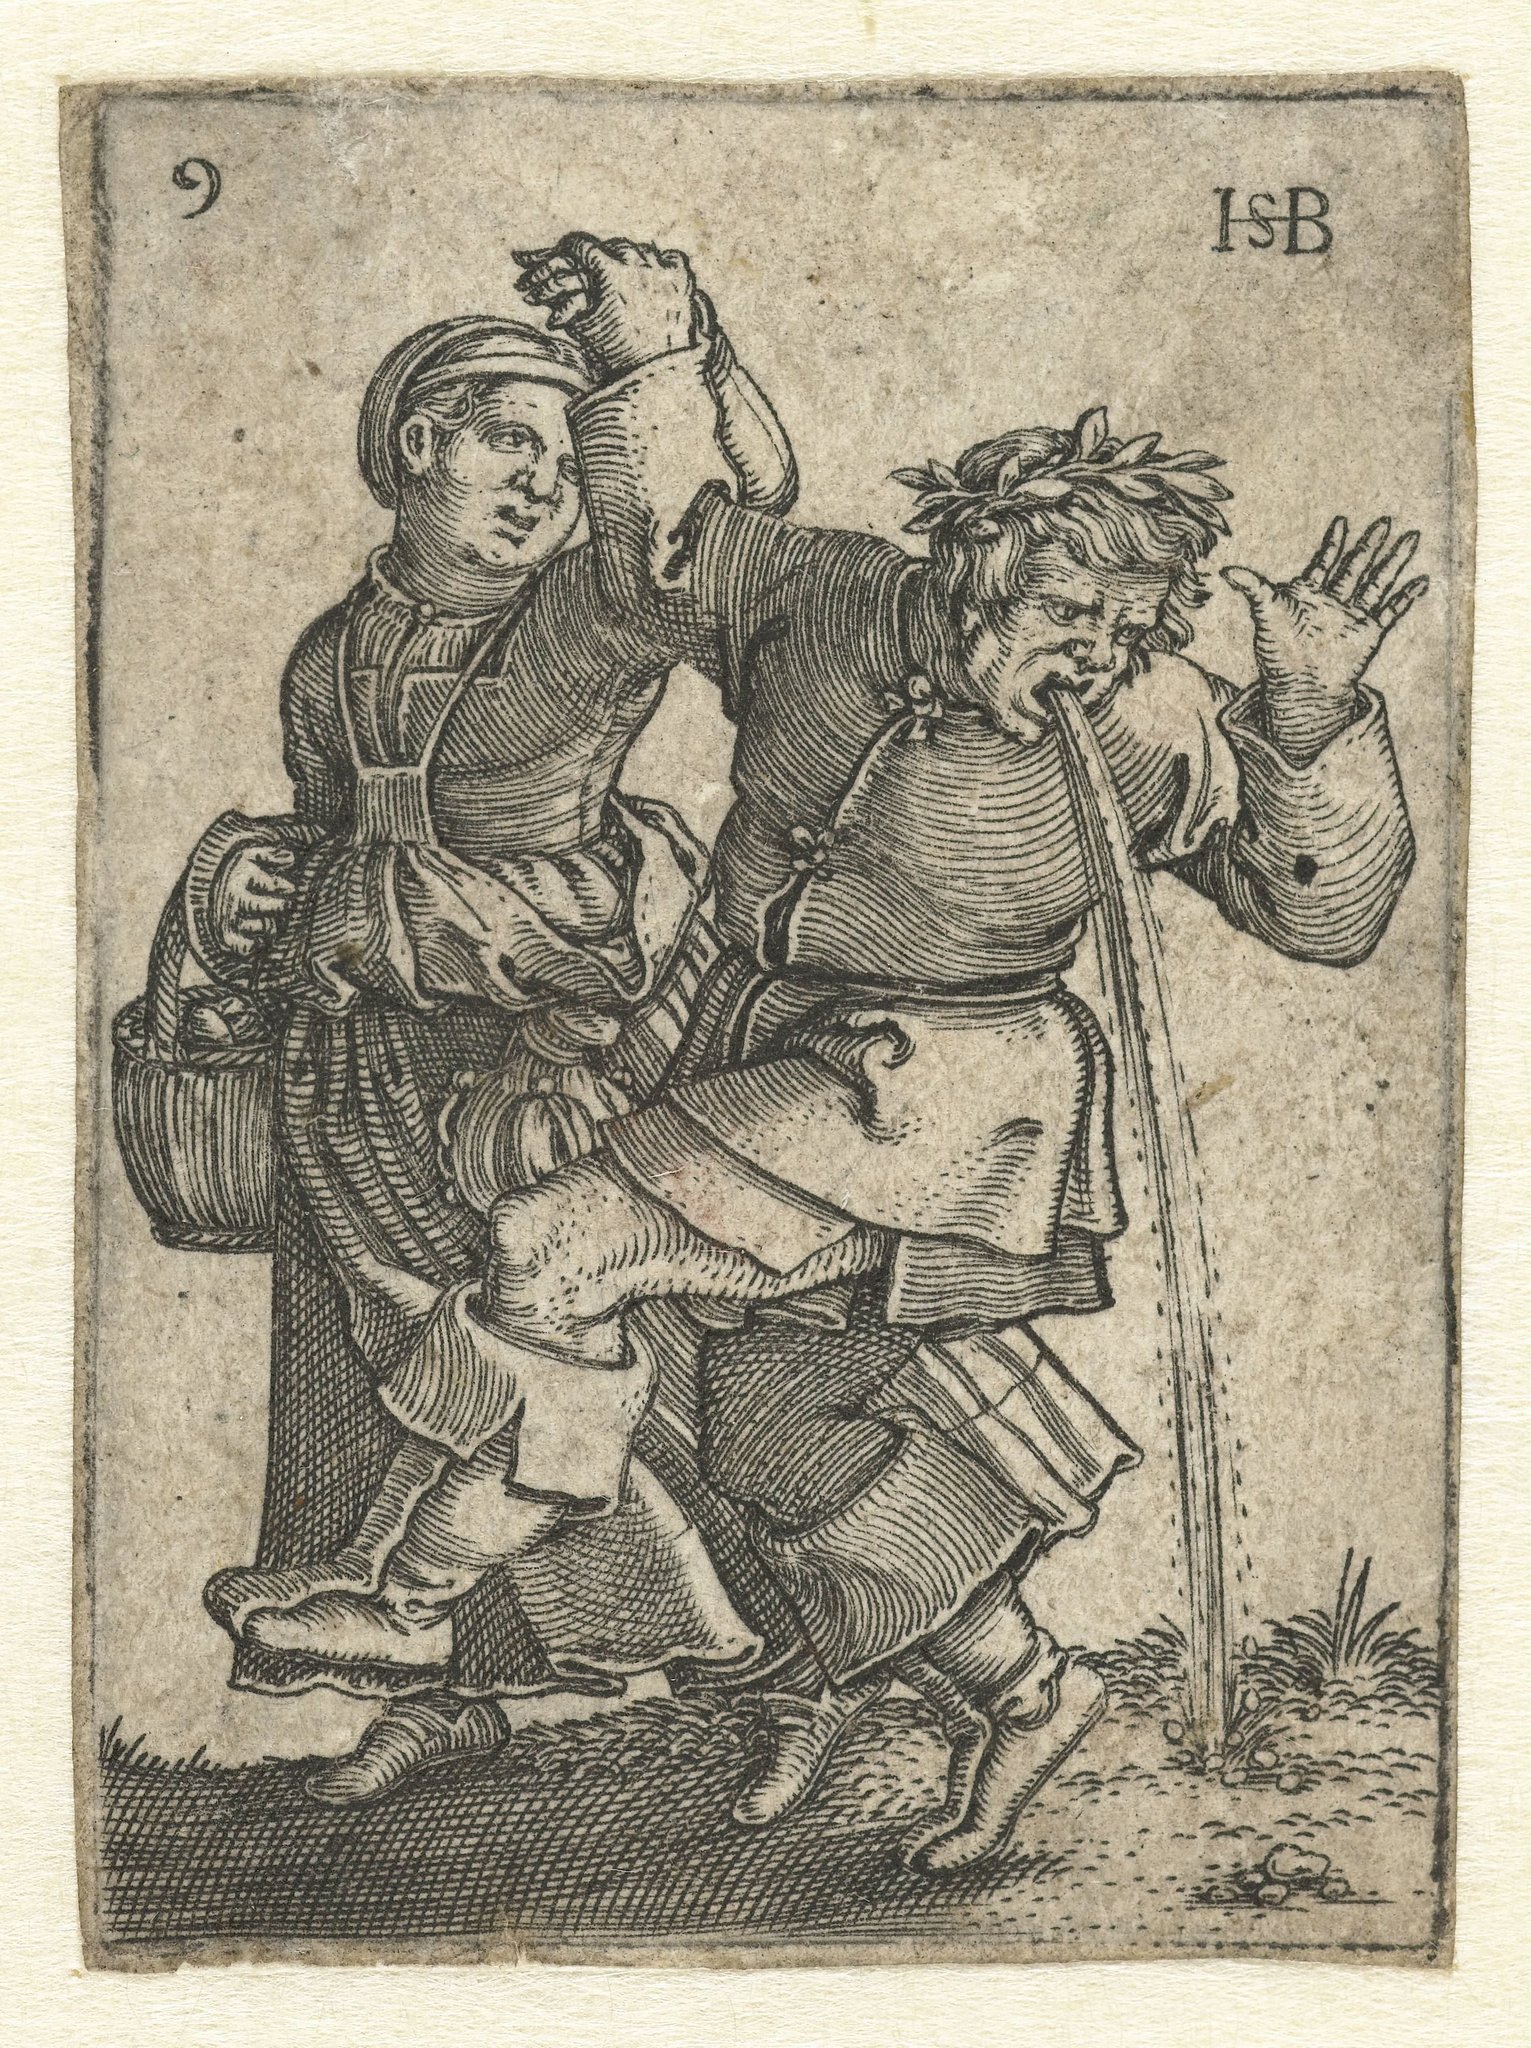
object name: print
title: Boerenfeest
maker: hans sebald beham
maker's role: designer, draughtsman, print maker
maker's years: 1500-1550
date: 1537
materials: paper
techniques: engraving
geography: frankfurt am main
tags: (annual) fair, trade fair, vomiting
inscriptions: collector's mark: Lugt 2228a